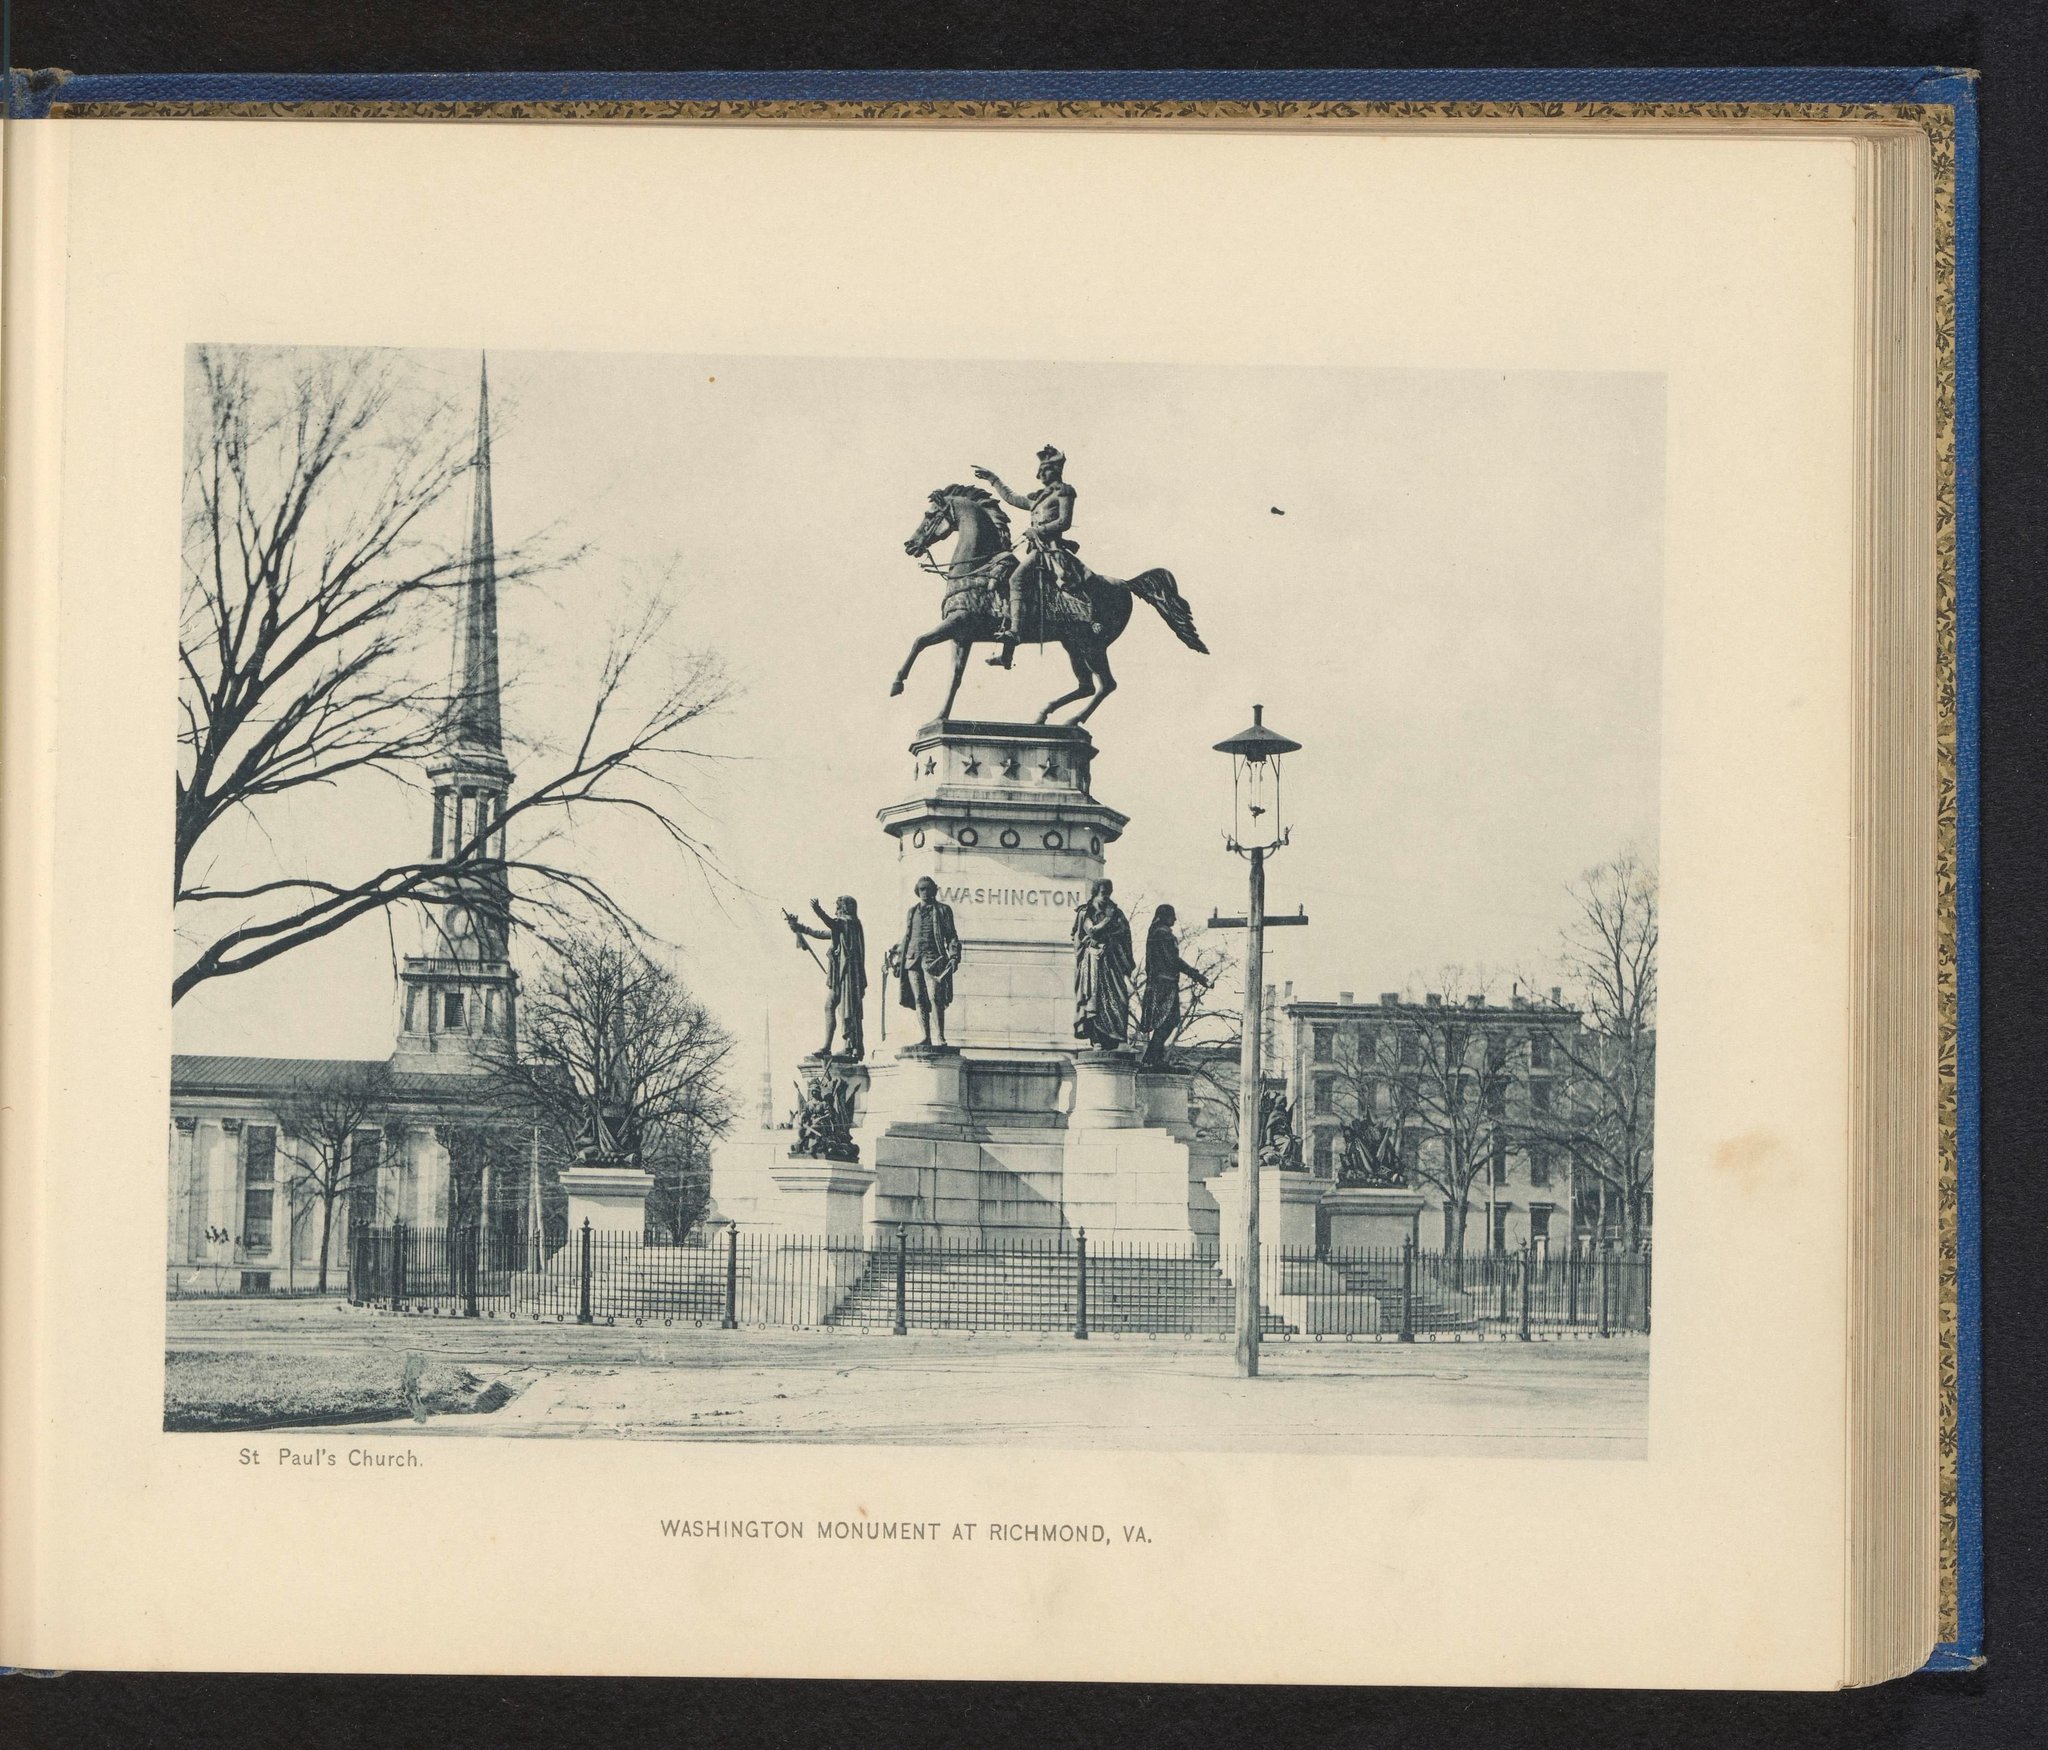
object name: page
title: Gezicht op het Virginia Washington Monument in Richmond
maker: Anonymous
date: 1883-1893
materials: paper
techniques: photograph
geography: richmond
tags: monument, statue